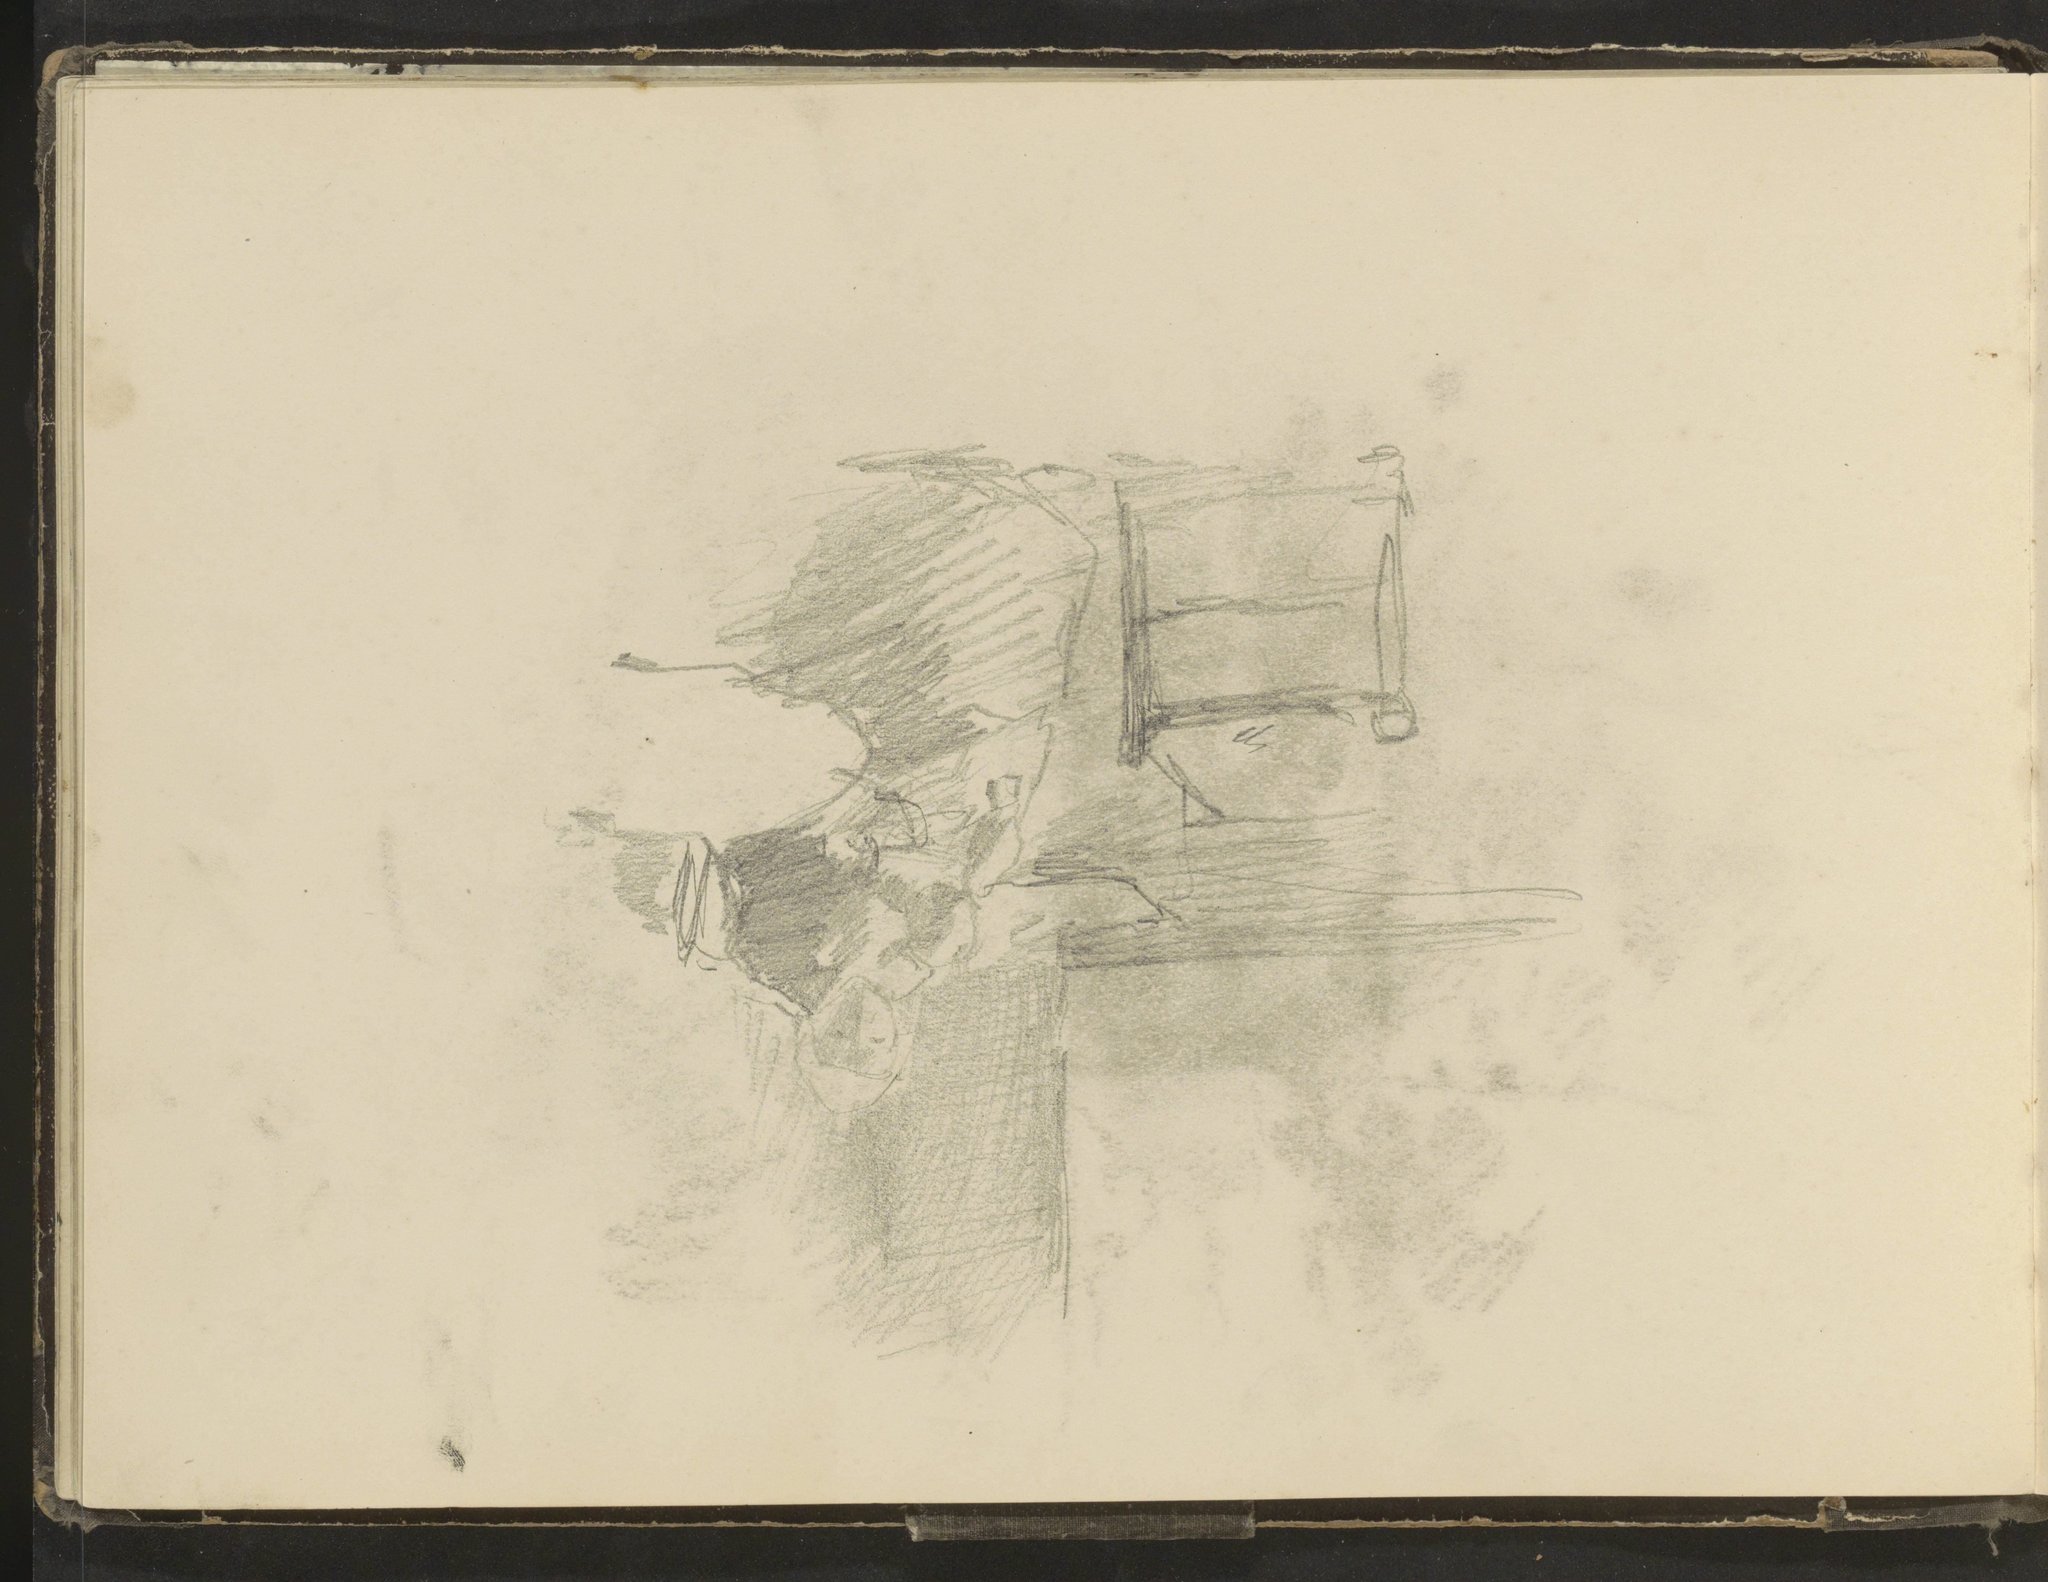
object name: sketchbook leaf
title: Vrouw met een baby op schoot in een interieur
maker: albert neuhuys (1844-1914)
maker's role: draughtsman, painter, print maker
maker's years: 1844-1914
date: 1854-1914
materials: paper, pencil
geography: laren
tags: sitting figure, adult woman, interior of the house, infant, baby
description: Blad 11 verso uit een schetsboek met 43 bladen.